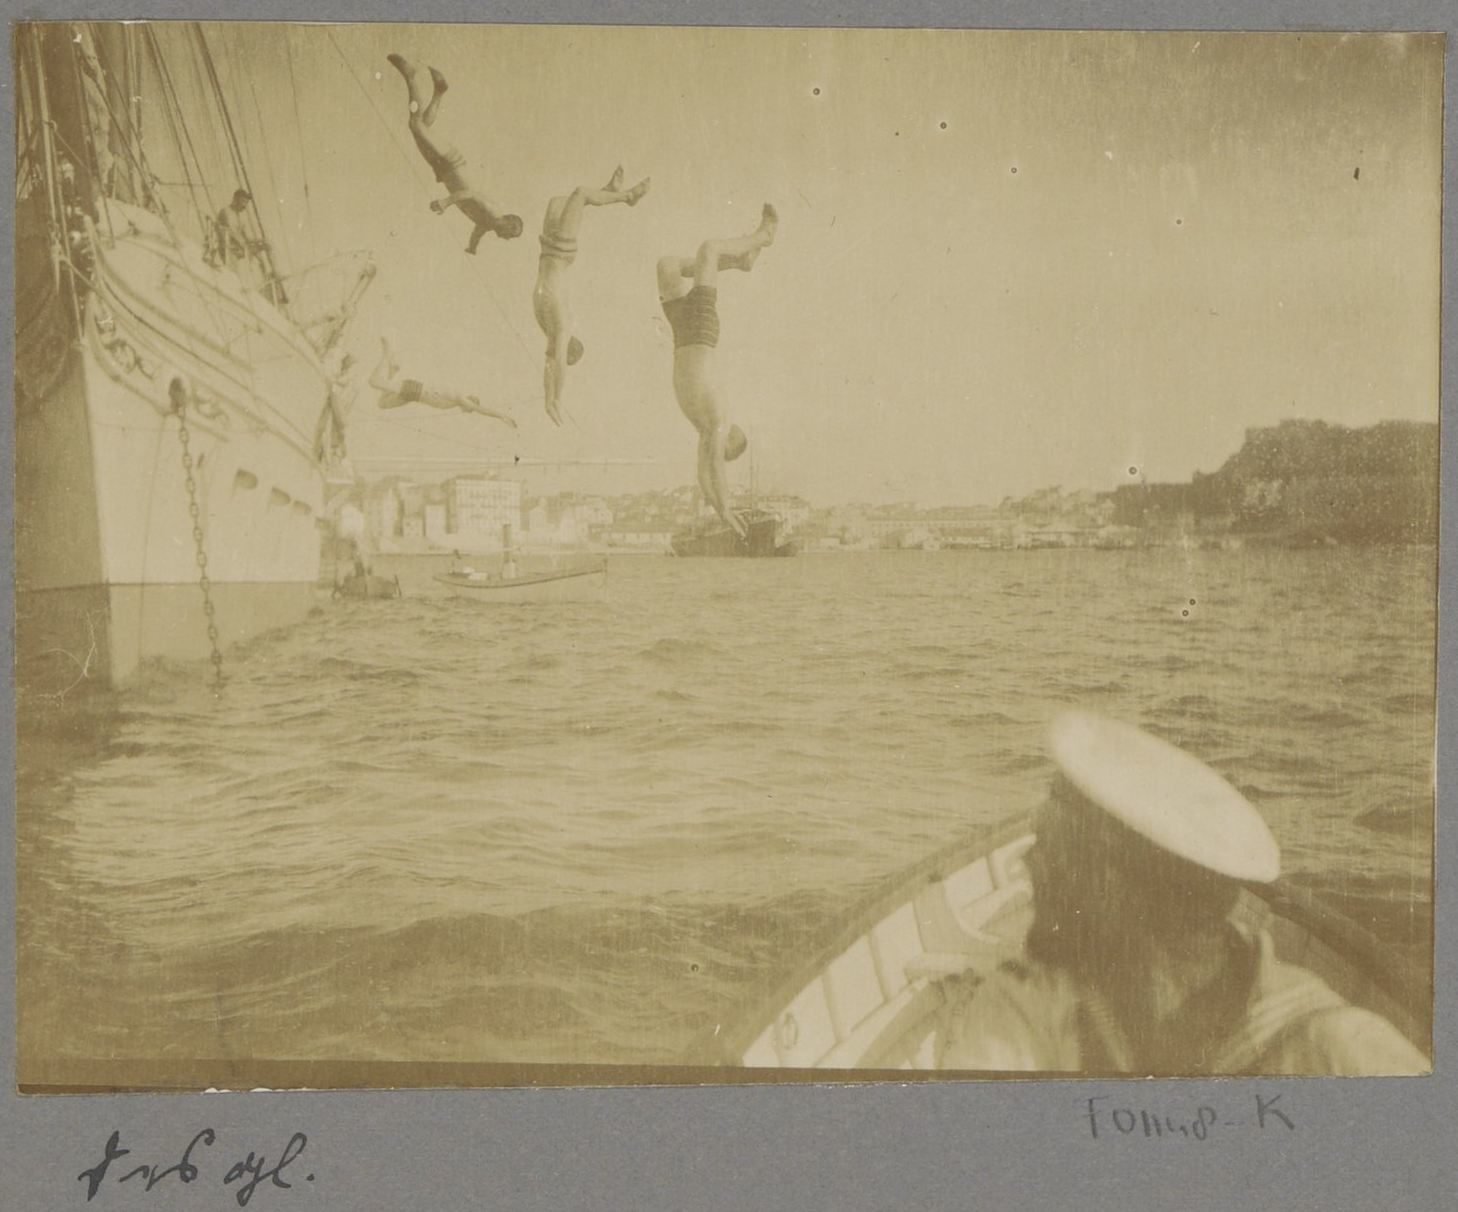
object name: album leaf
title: Mannen duiken vanaf S.M.S. Loreley in zee bij Corfu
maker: Anonymous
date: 1905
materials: paper, photographic support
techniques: gelatin silver print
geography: corfu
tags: diving (movement in water)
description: Onderdeel van Reisalbum met foto's van bezienswaardigheden in Griekenland en Egypte.